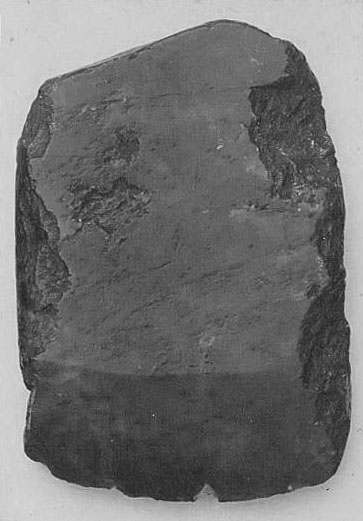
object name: adze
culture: north american, alaskan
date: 1902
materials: jade